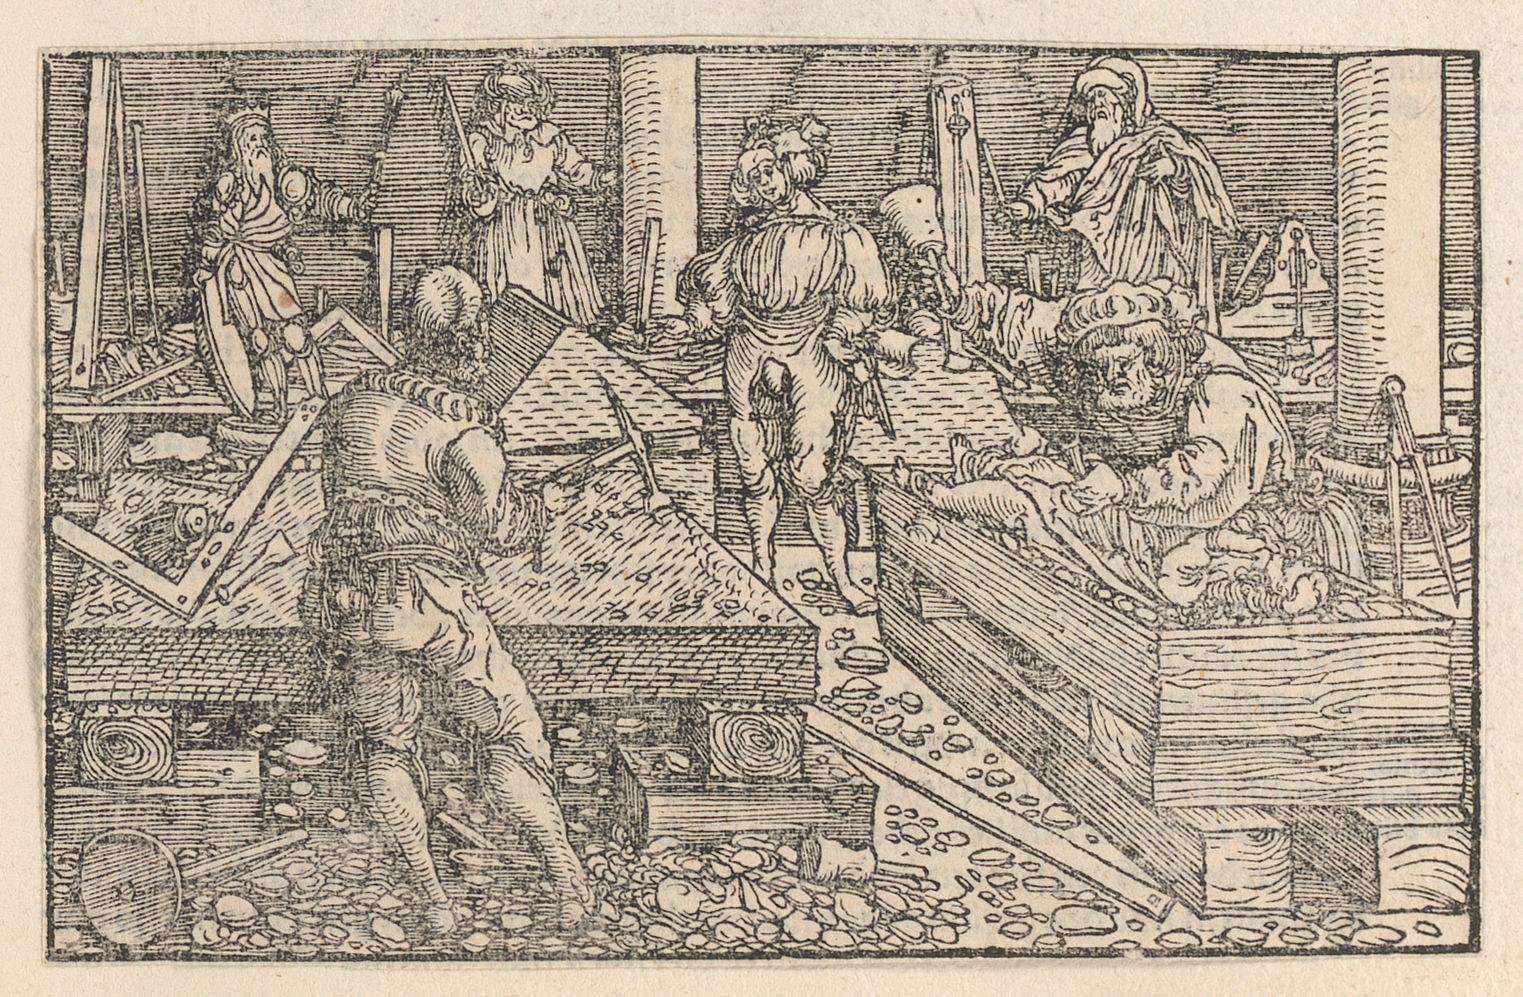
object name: book illustration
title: Beeldhouwers in een werkplaats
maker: Anonymous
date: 1514-1532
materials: paper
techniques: letterpress printing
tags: sculptor at work, artist at work, in his workshop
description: Deze prent is gebruikt in: Petrarca, Francesco. Von der Artzney bayder Glück, des guten und widerwertigen: unnd weß sich ain yeder inn Gelück und Unglück halten sol (...). Augsburg: Heinrich Steiner, 1532. Deze uitgave is ook bekend onder de titel 'Trostspiegel in Glück und Unglück'.